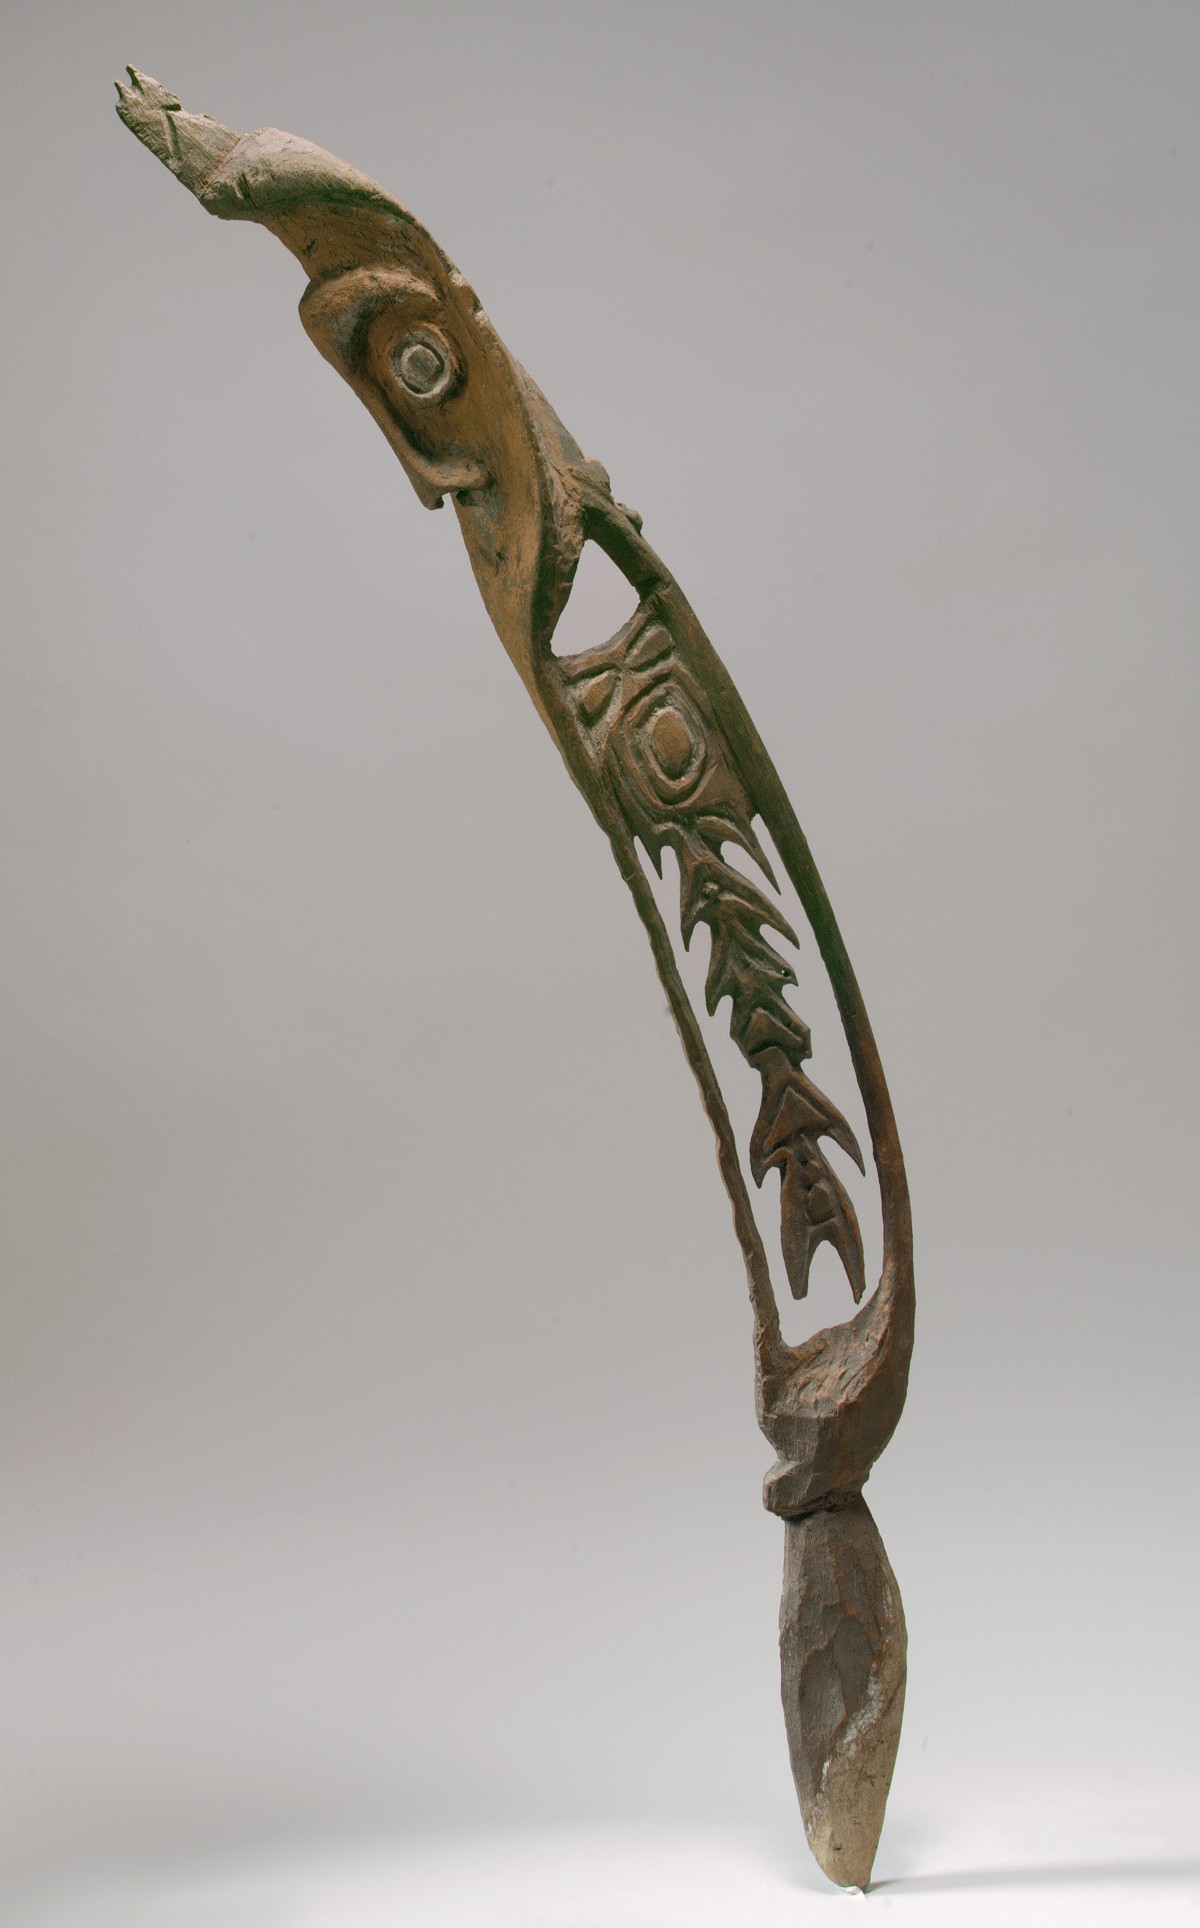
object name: figure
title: Male Figure (Aripa)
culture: inyai-ewa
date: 1501-1900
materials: paint, wood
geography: papua new guinea